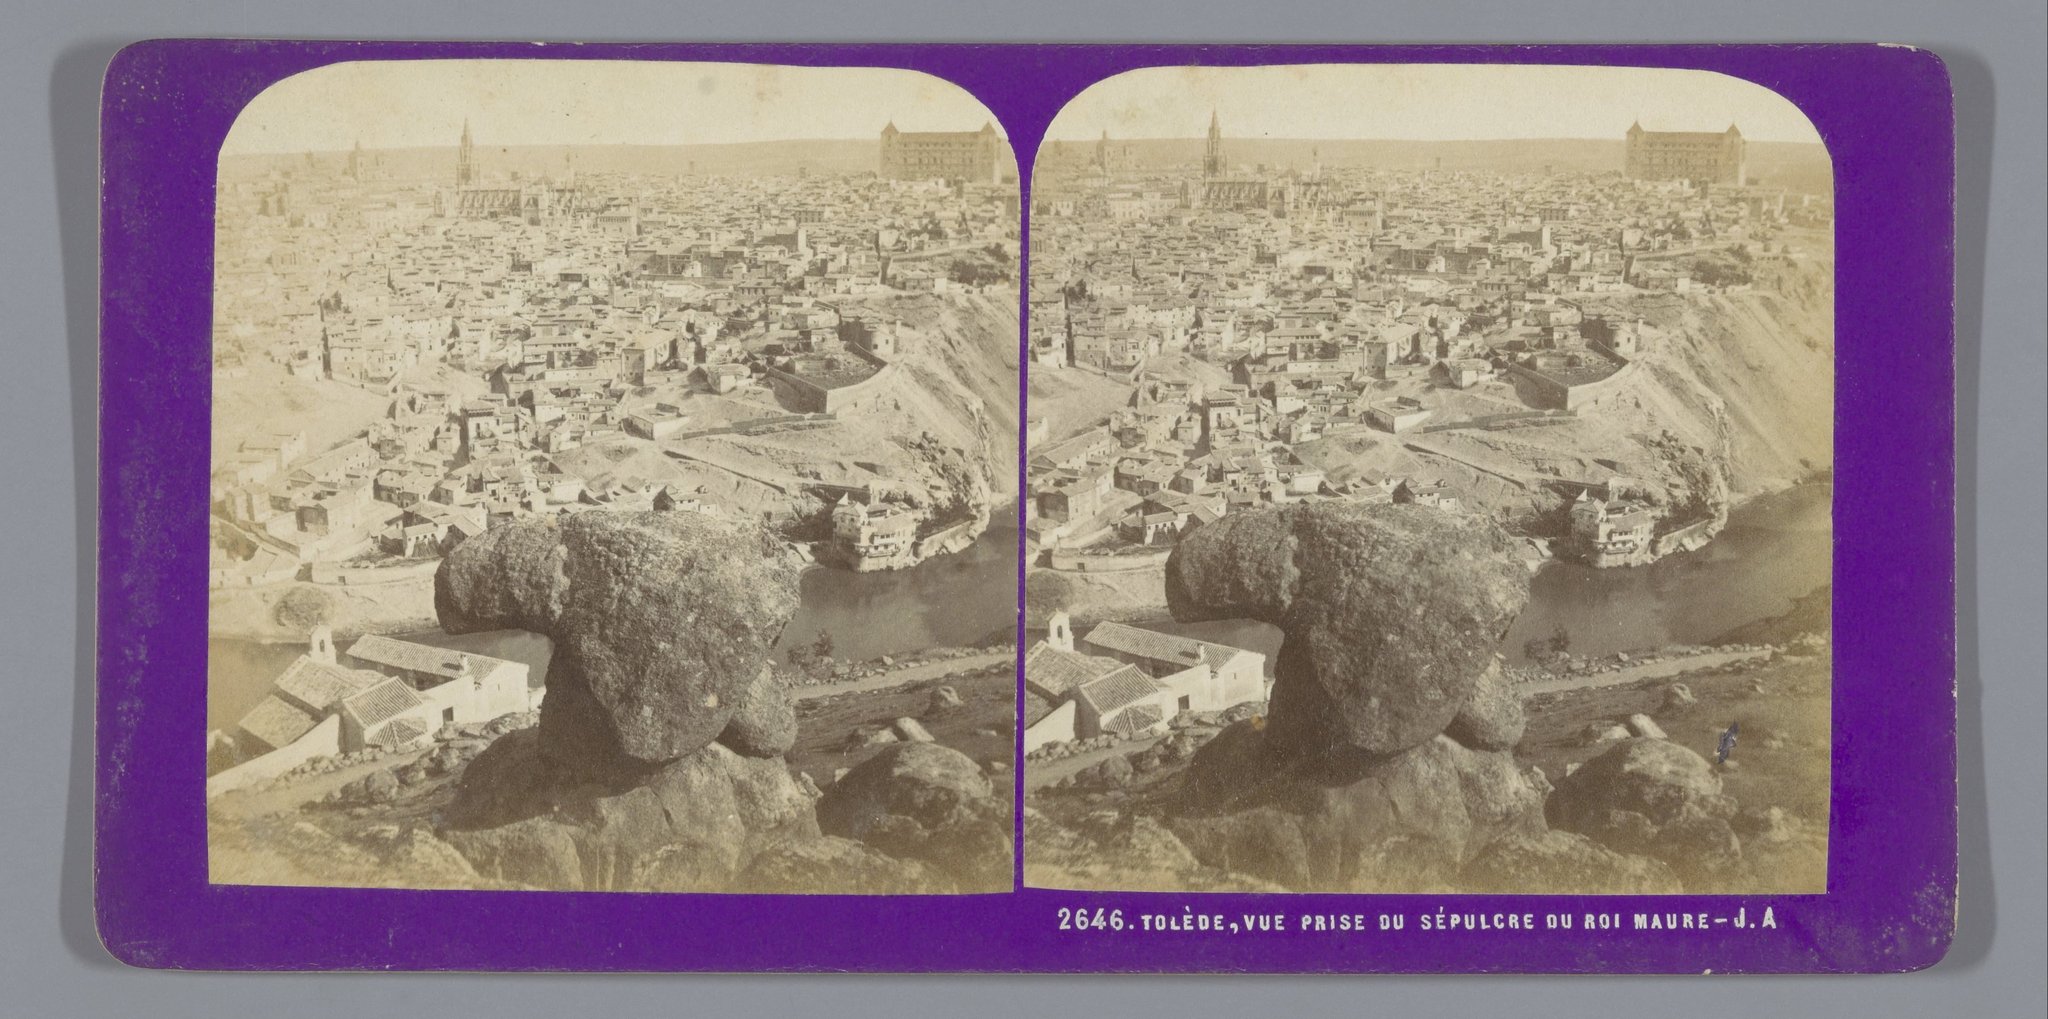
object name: stereograph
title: TOLÈDE, VUE PRISE DU SÉPULCRE DU ROI MAURE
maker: jean andrieu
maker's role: fotograaf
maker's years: 1816-1872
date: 1862-1876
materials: cardboard, photographic support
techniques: albumen print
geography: castilla-la mancha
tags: city-view in general; 'veduta'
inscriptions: number: ‘2646.’